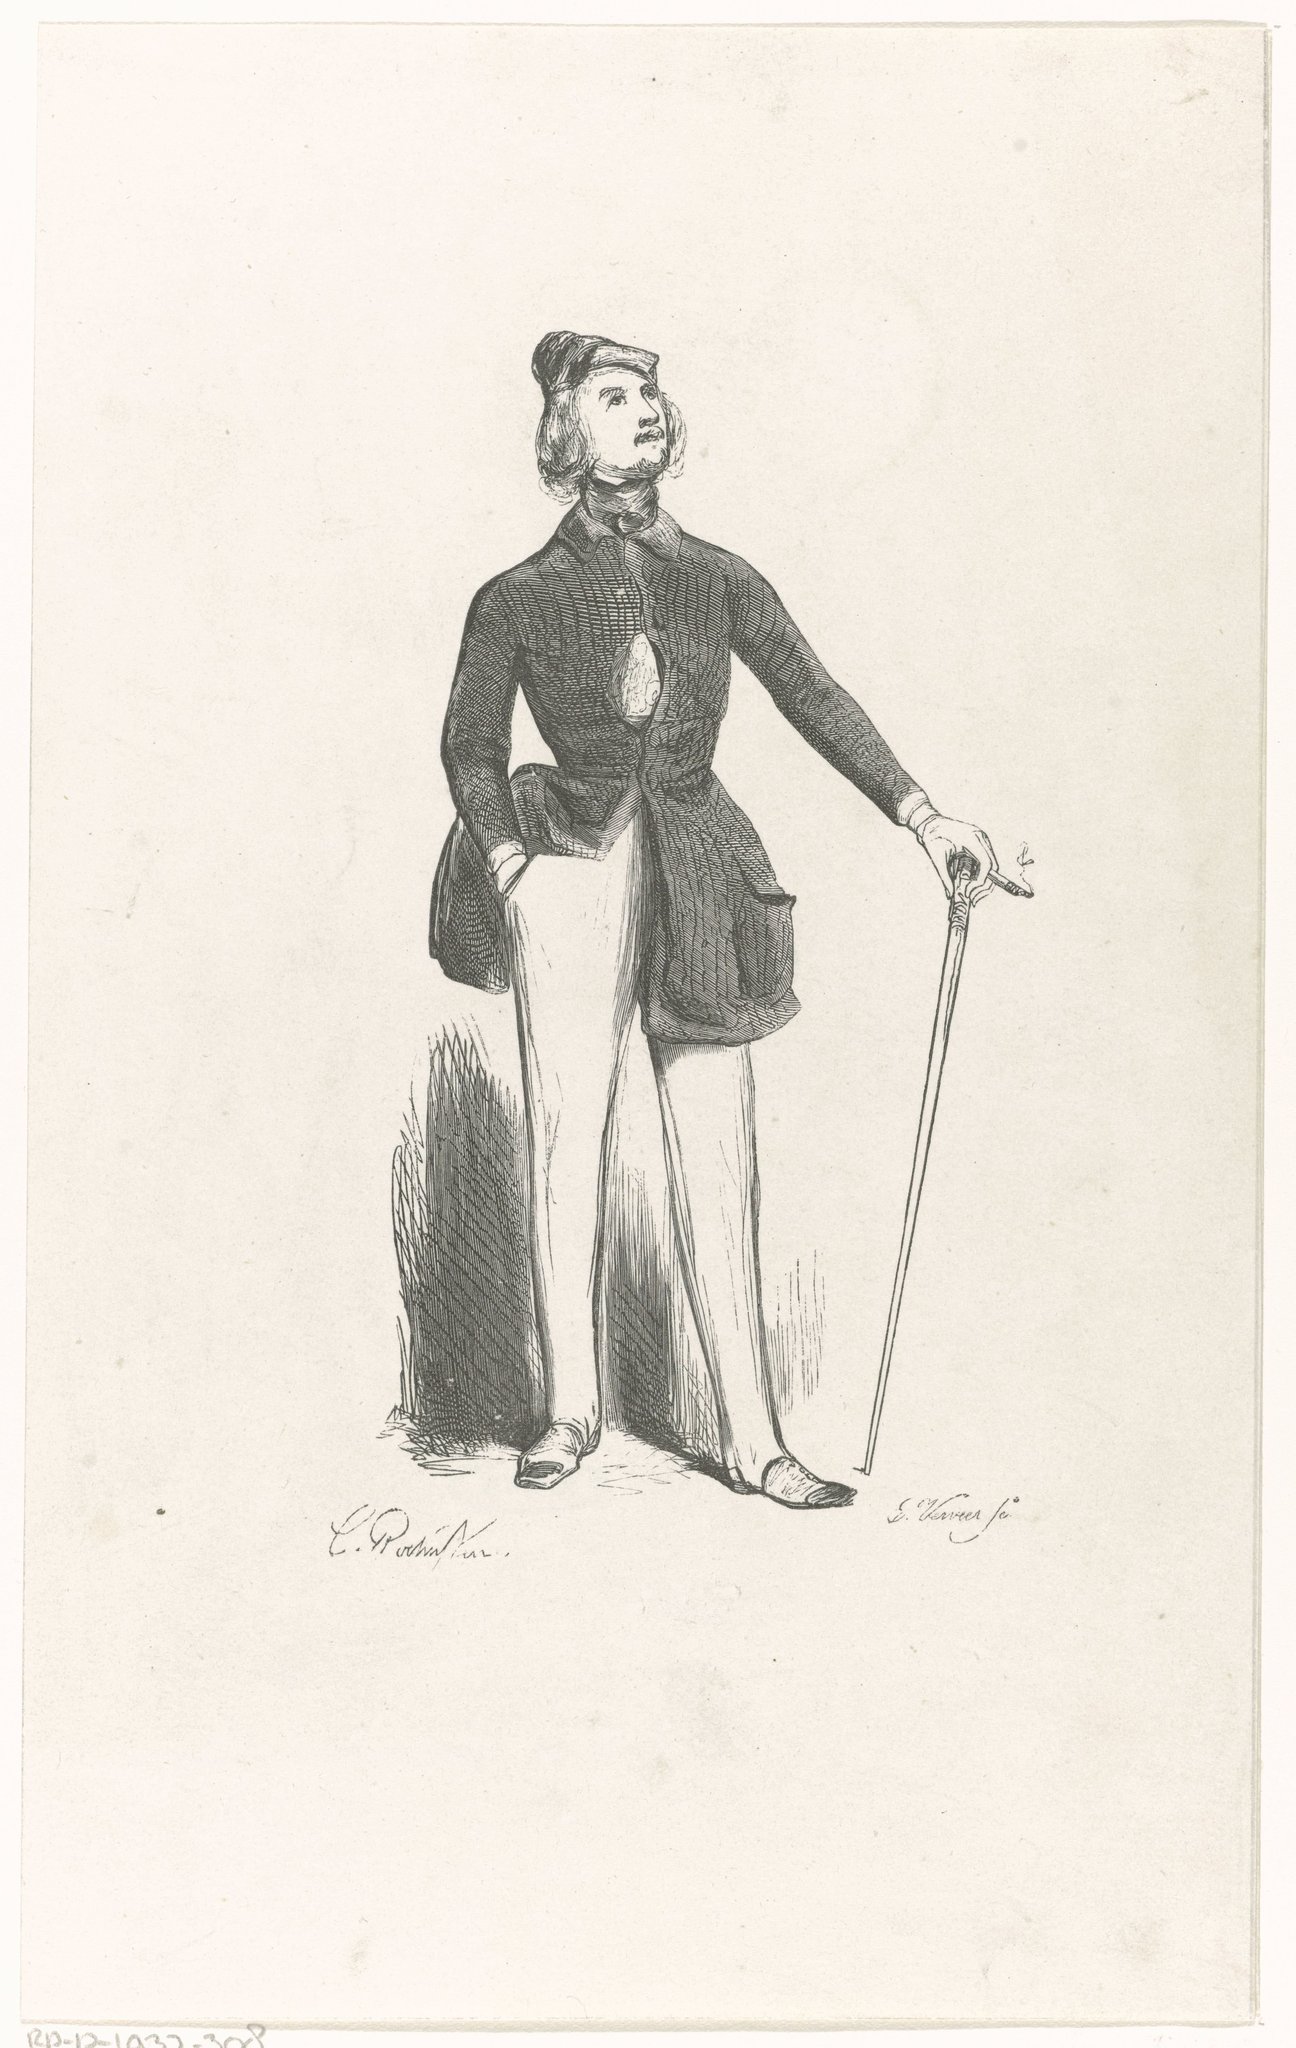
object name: print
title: Man met een wandelstok en een sigaar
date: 1836-1900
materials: paper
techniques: engraving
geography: the hague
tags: cigar, walking-stick, staff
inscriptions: collector's mark: Lugt 2760, collector's mark: Lugt 2228